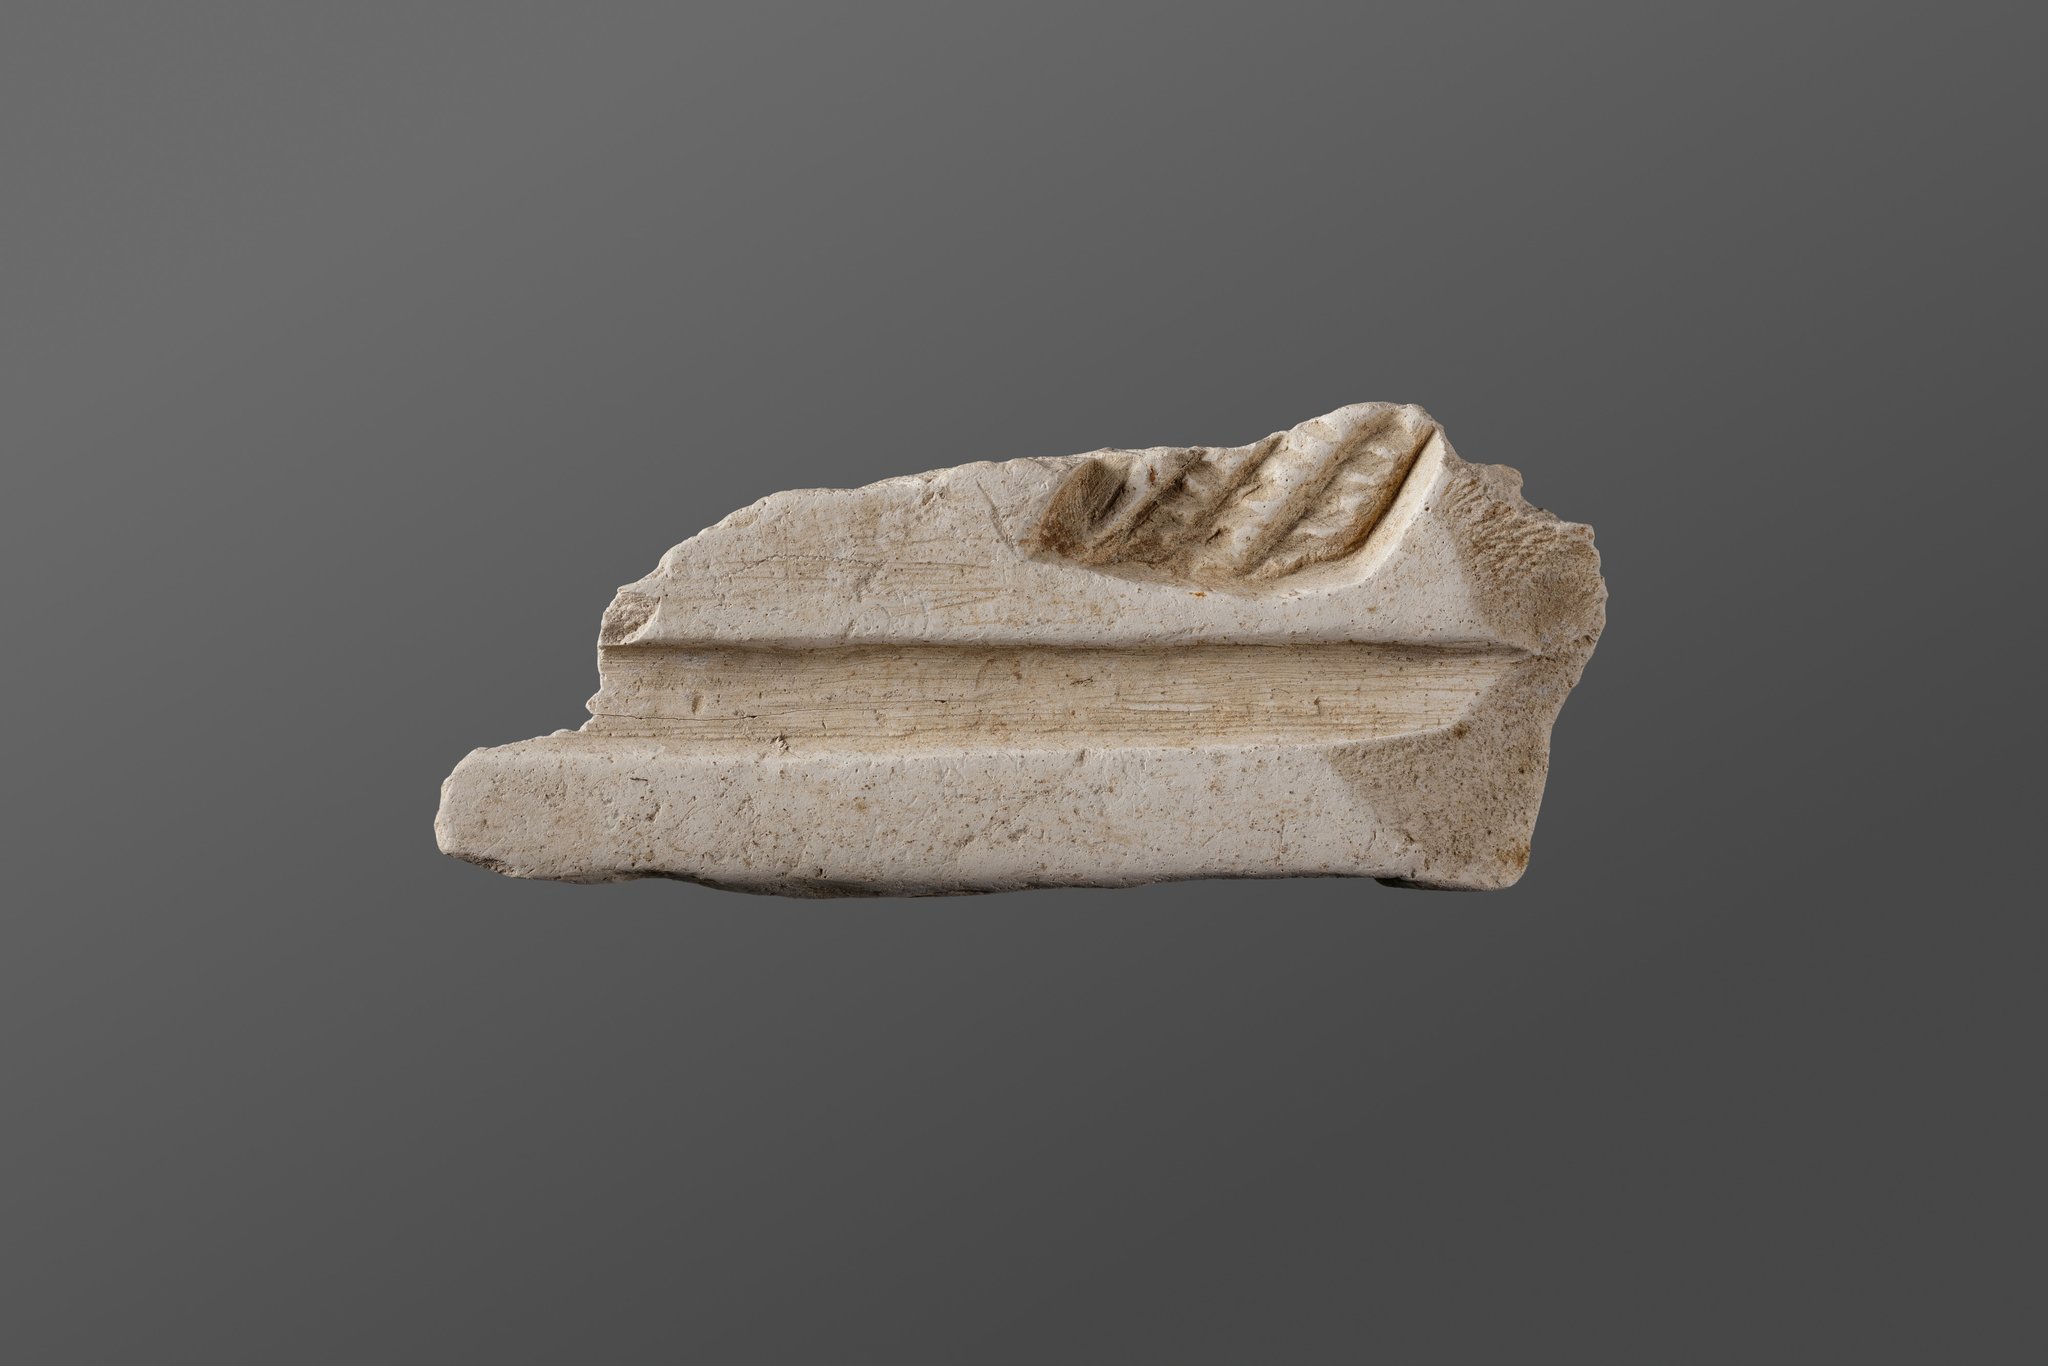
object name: relief fragment 47, tomb of mereri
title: Relief fragment possibly from the tomb of Mereri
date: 2100-2090 BCE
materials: stone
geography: egypt